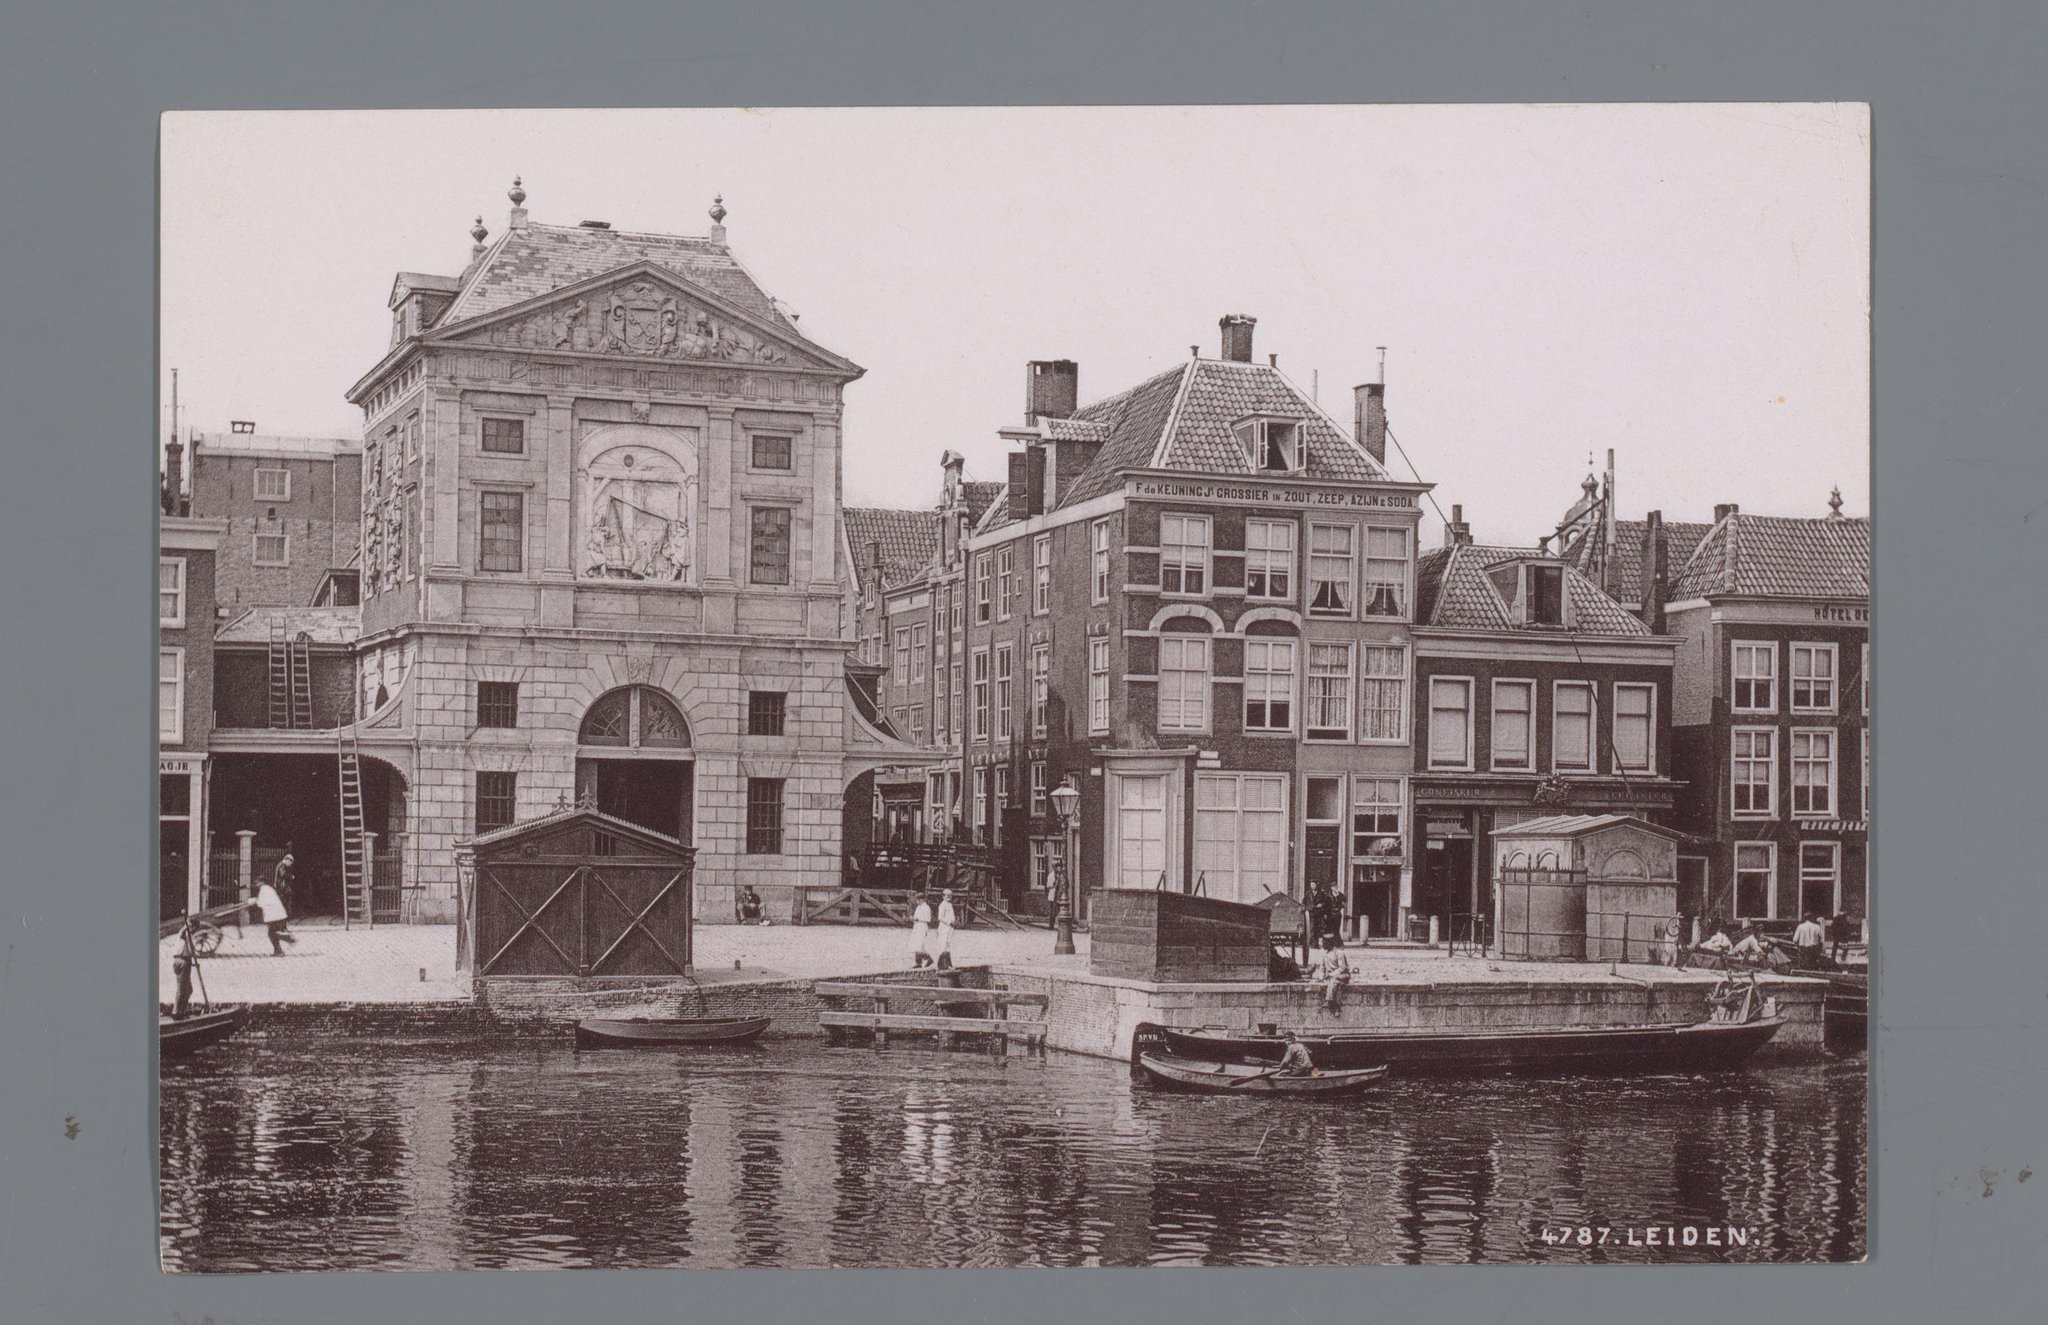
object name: photomechanical print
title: Gezicht op de Waag te Leiden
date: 1880-1910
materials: paper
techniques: photograph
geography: dresden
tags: weigh-house, street (+ city(-scape) with figures, staffage), leiden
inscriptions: inscription: ‘4787. Leiden.’